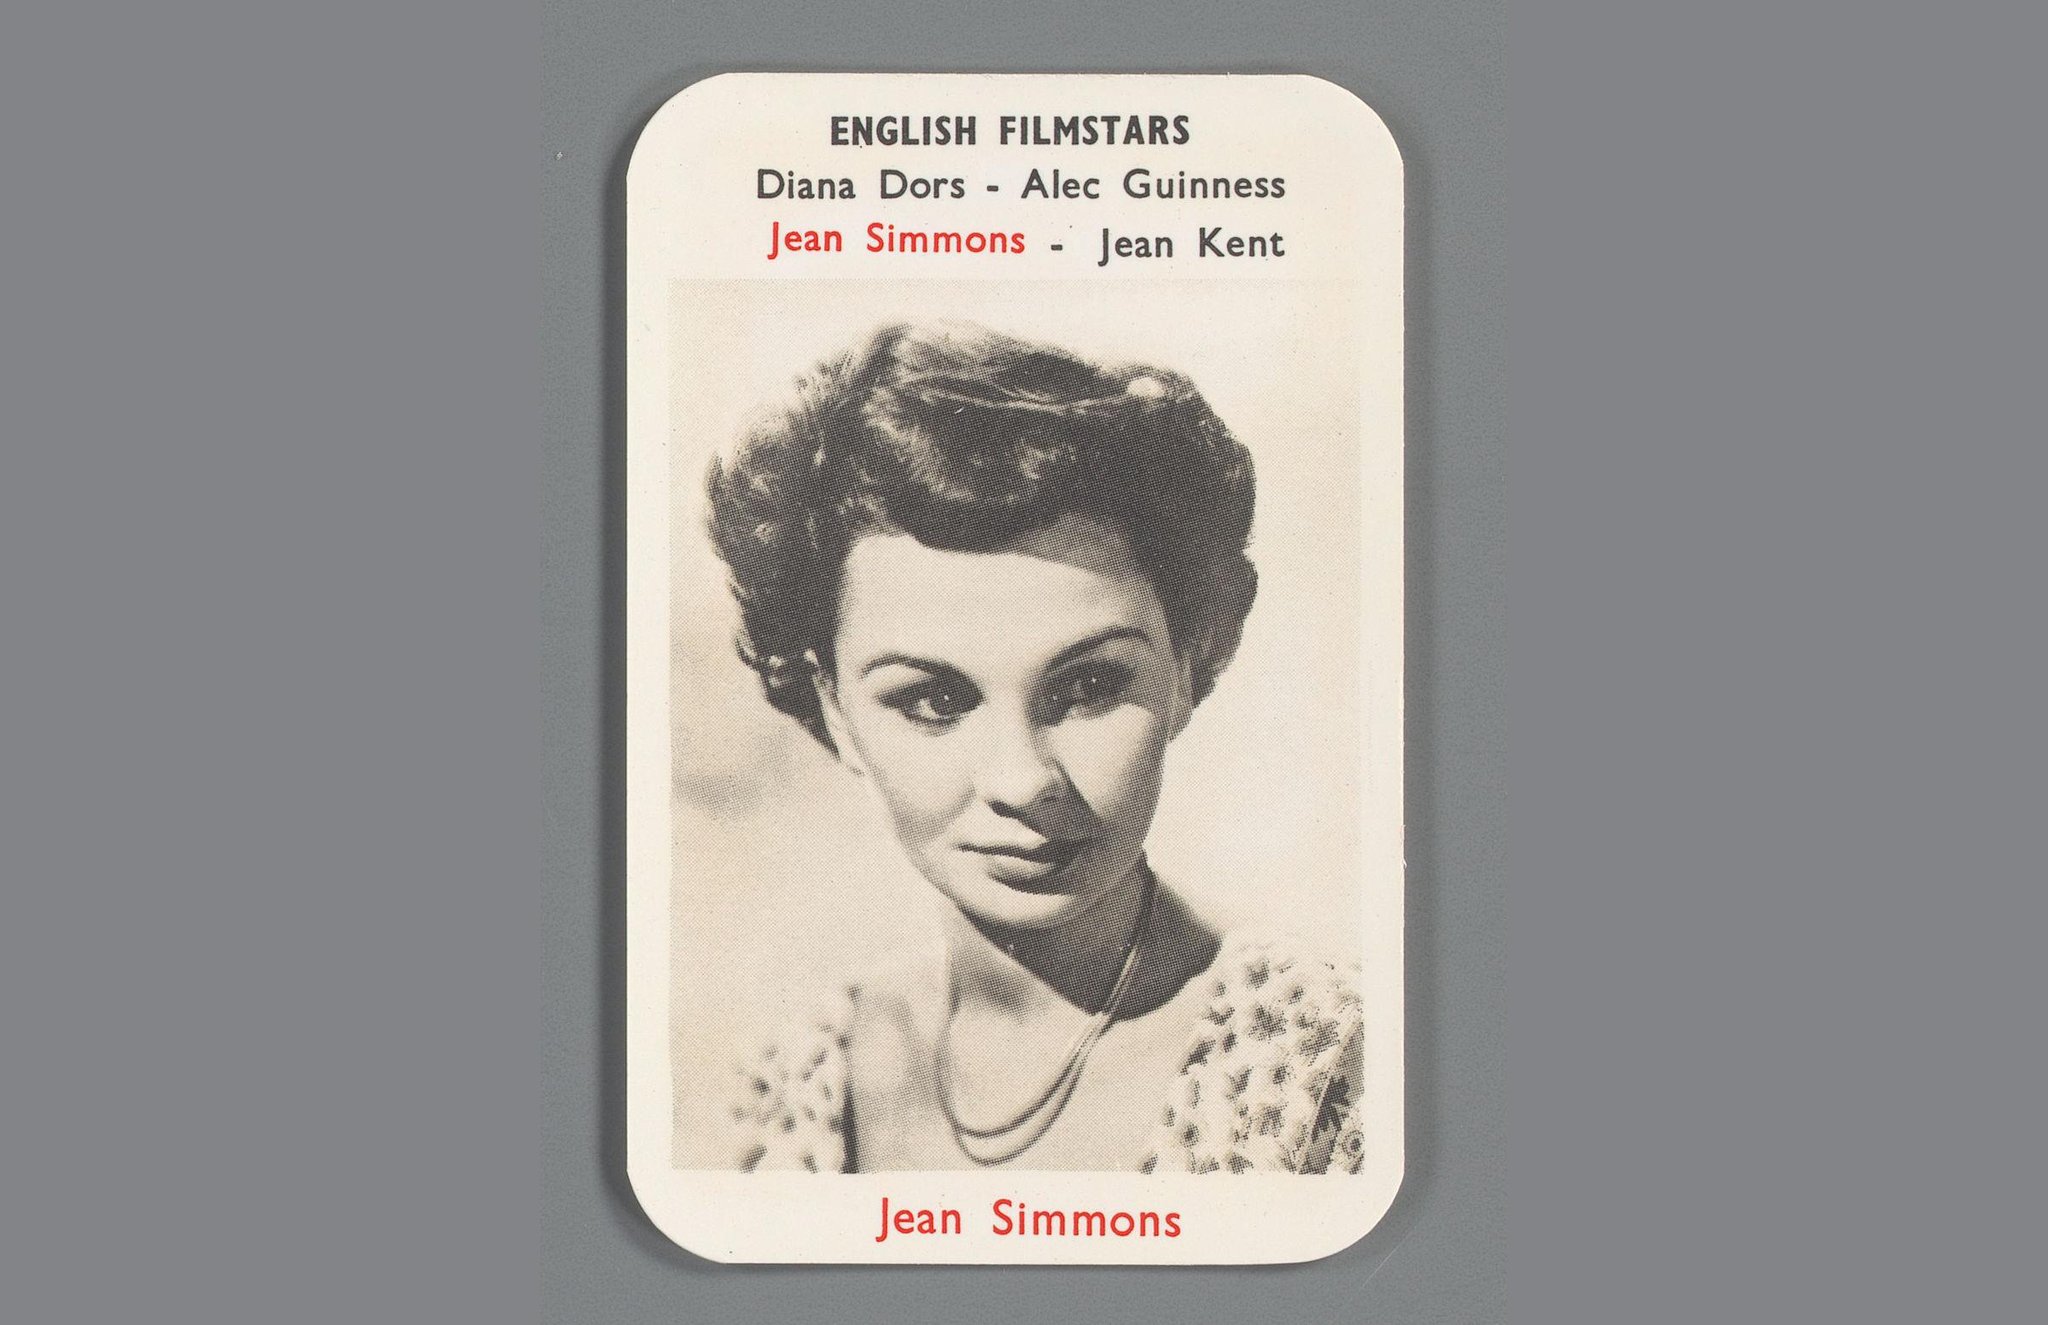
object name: playing card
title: English Filmstars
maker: Anonymous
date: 1960-1970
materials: paper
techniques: autotype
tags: london, portrait of actor, actress